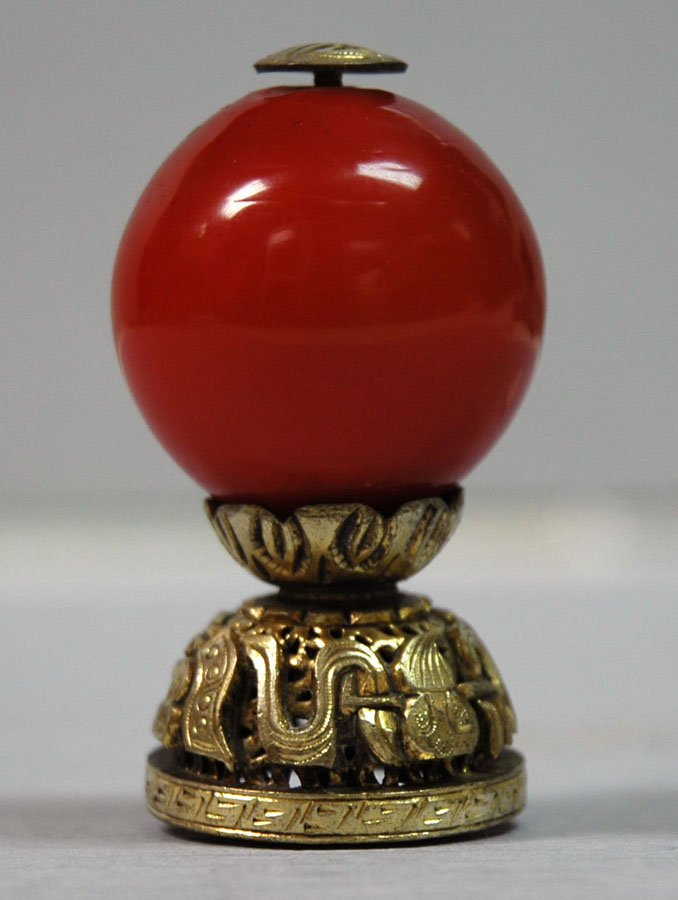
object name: hat finial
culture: chinese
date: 1644-1911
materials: glass, metal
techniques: gilding